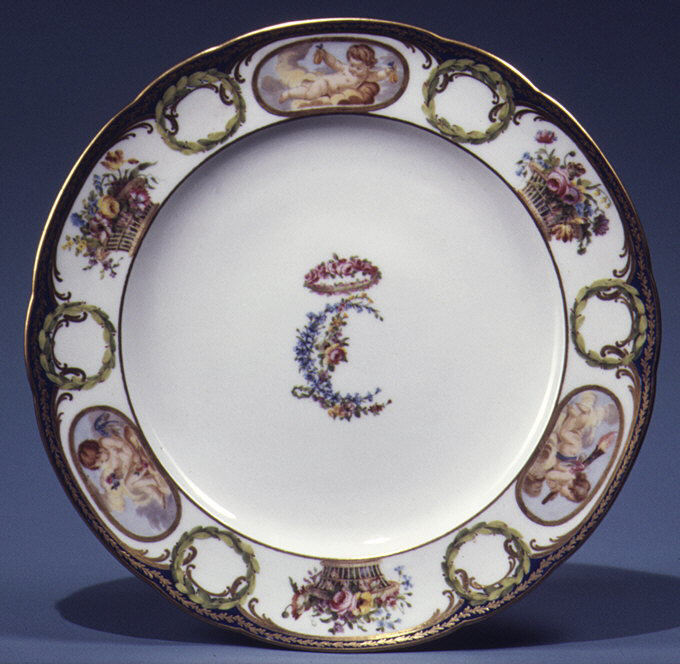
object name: plate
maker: sèvres manufactory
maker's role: manufactory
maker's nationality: french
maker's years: 1740-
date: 1773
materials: soft paste porcelain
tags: putti,flowers,insignia